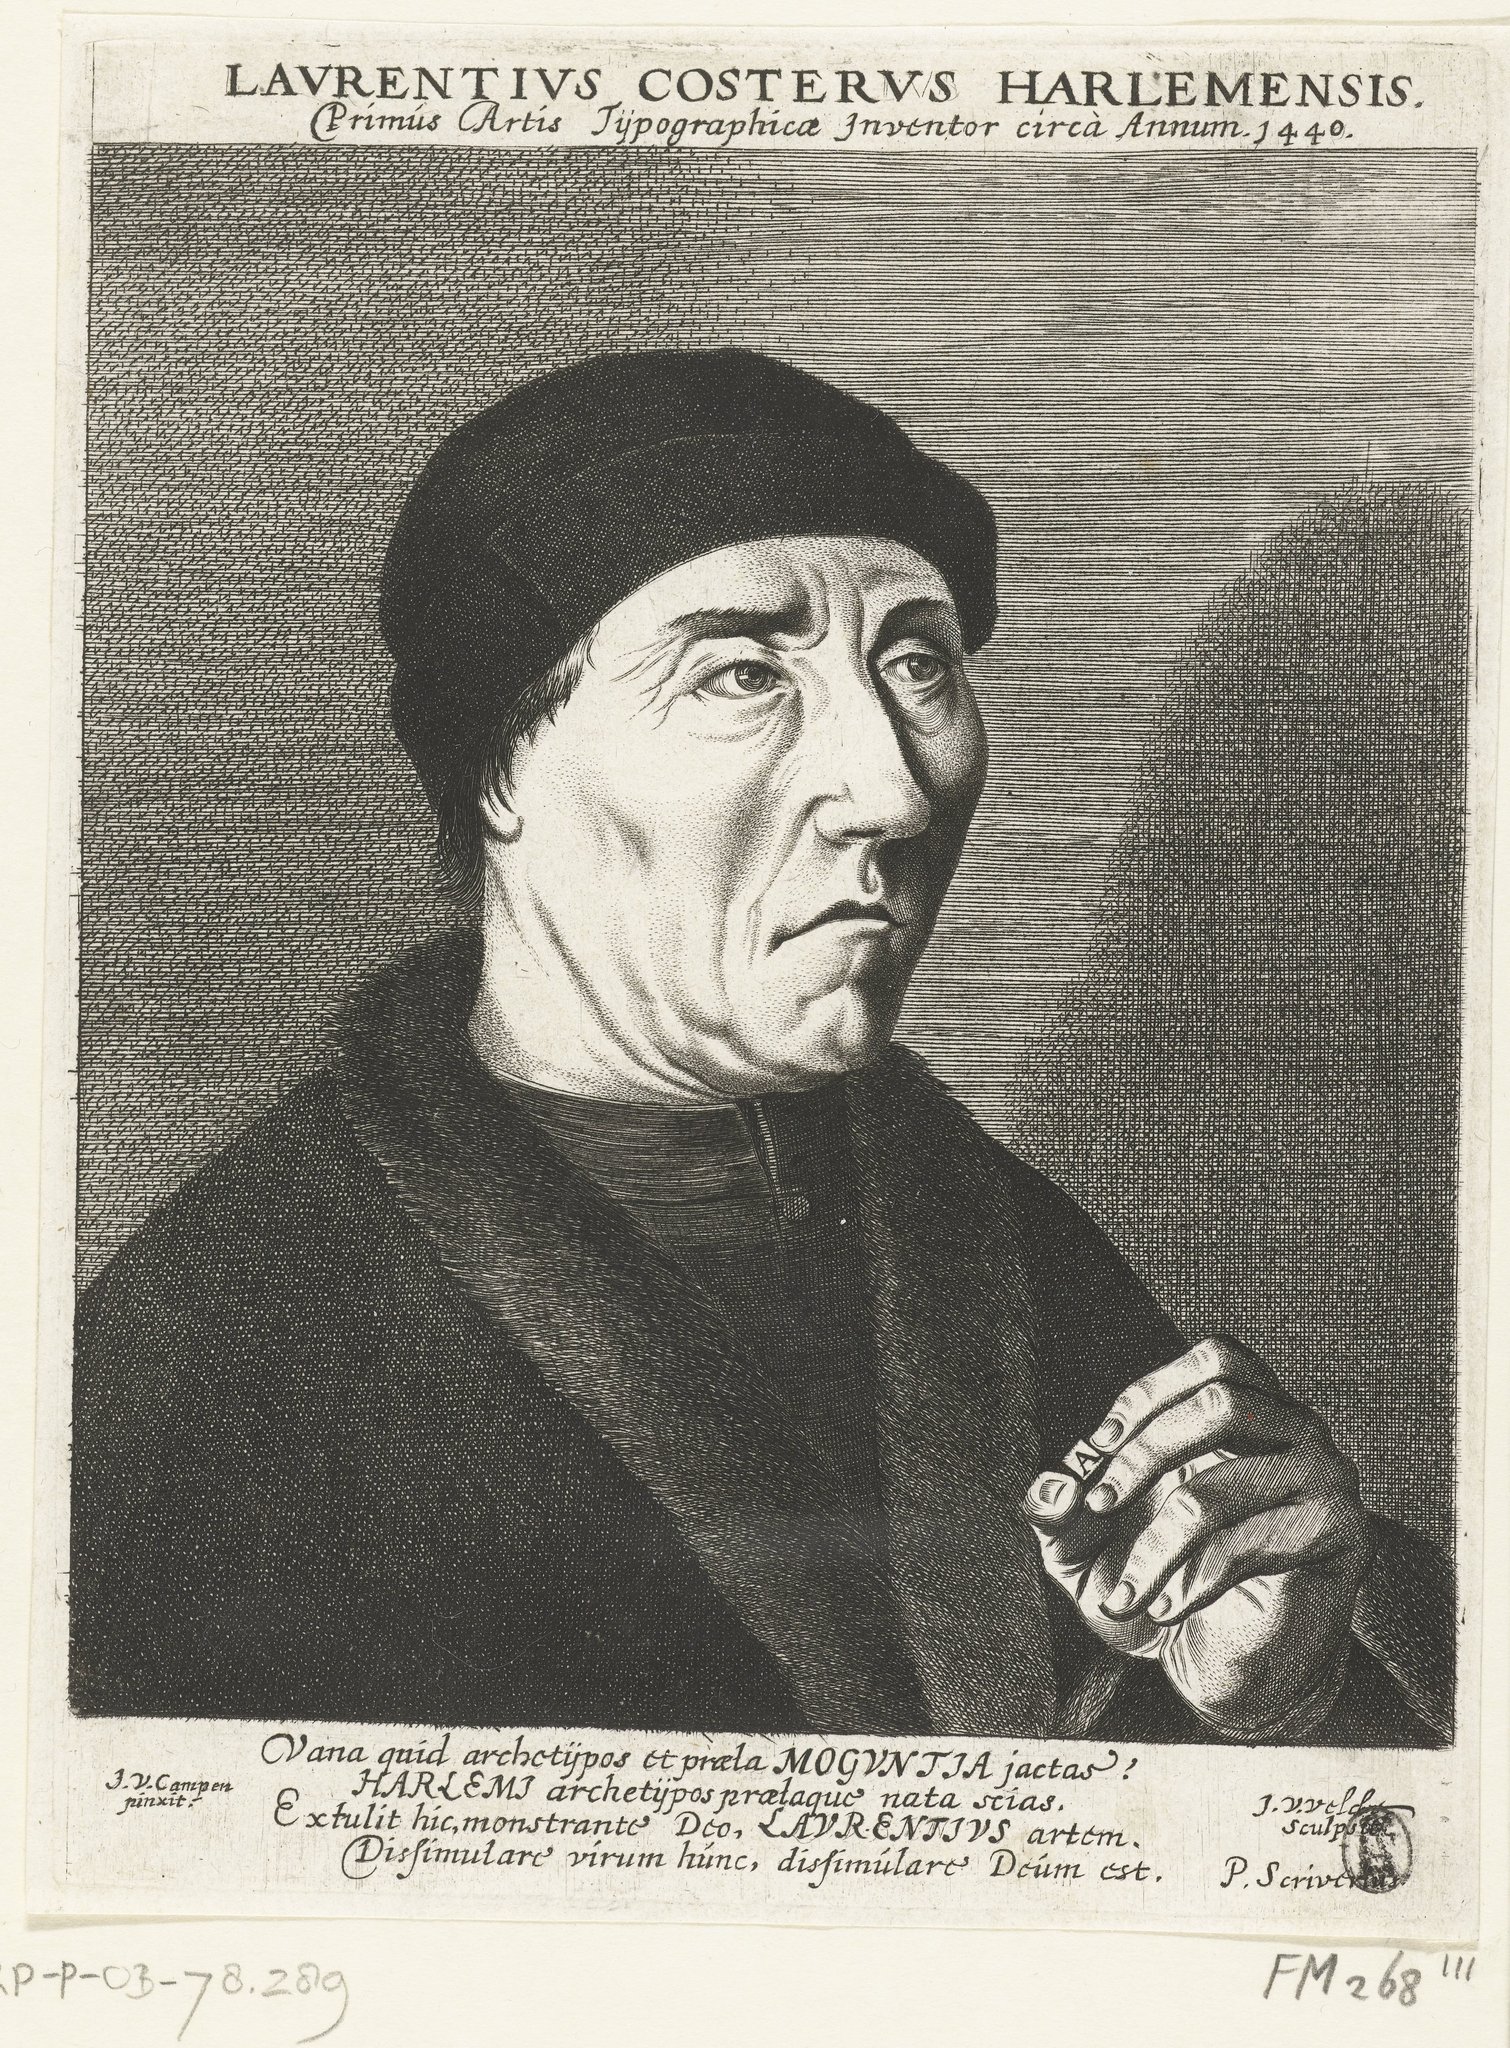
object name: history print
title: Lavrentivs Costervs Harlemensis. Primus Artis Tijpographicae Inventor circa Annum 1440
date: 1626-1628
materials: paper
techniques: engraving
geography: northern netherlands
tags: haarlem, printer, burgundian netherlands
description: Illustratie voor: Ampzing, Samuel. Beschryvinge ende lof der stad Haerlem in Holland […]. Haarlem: Adriaen Roman (I), 1628.